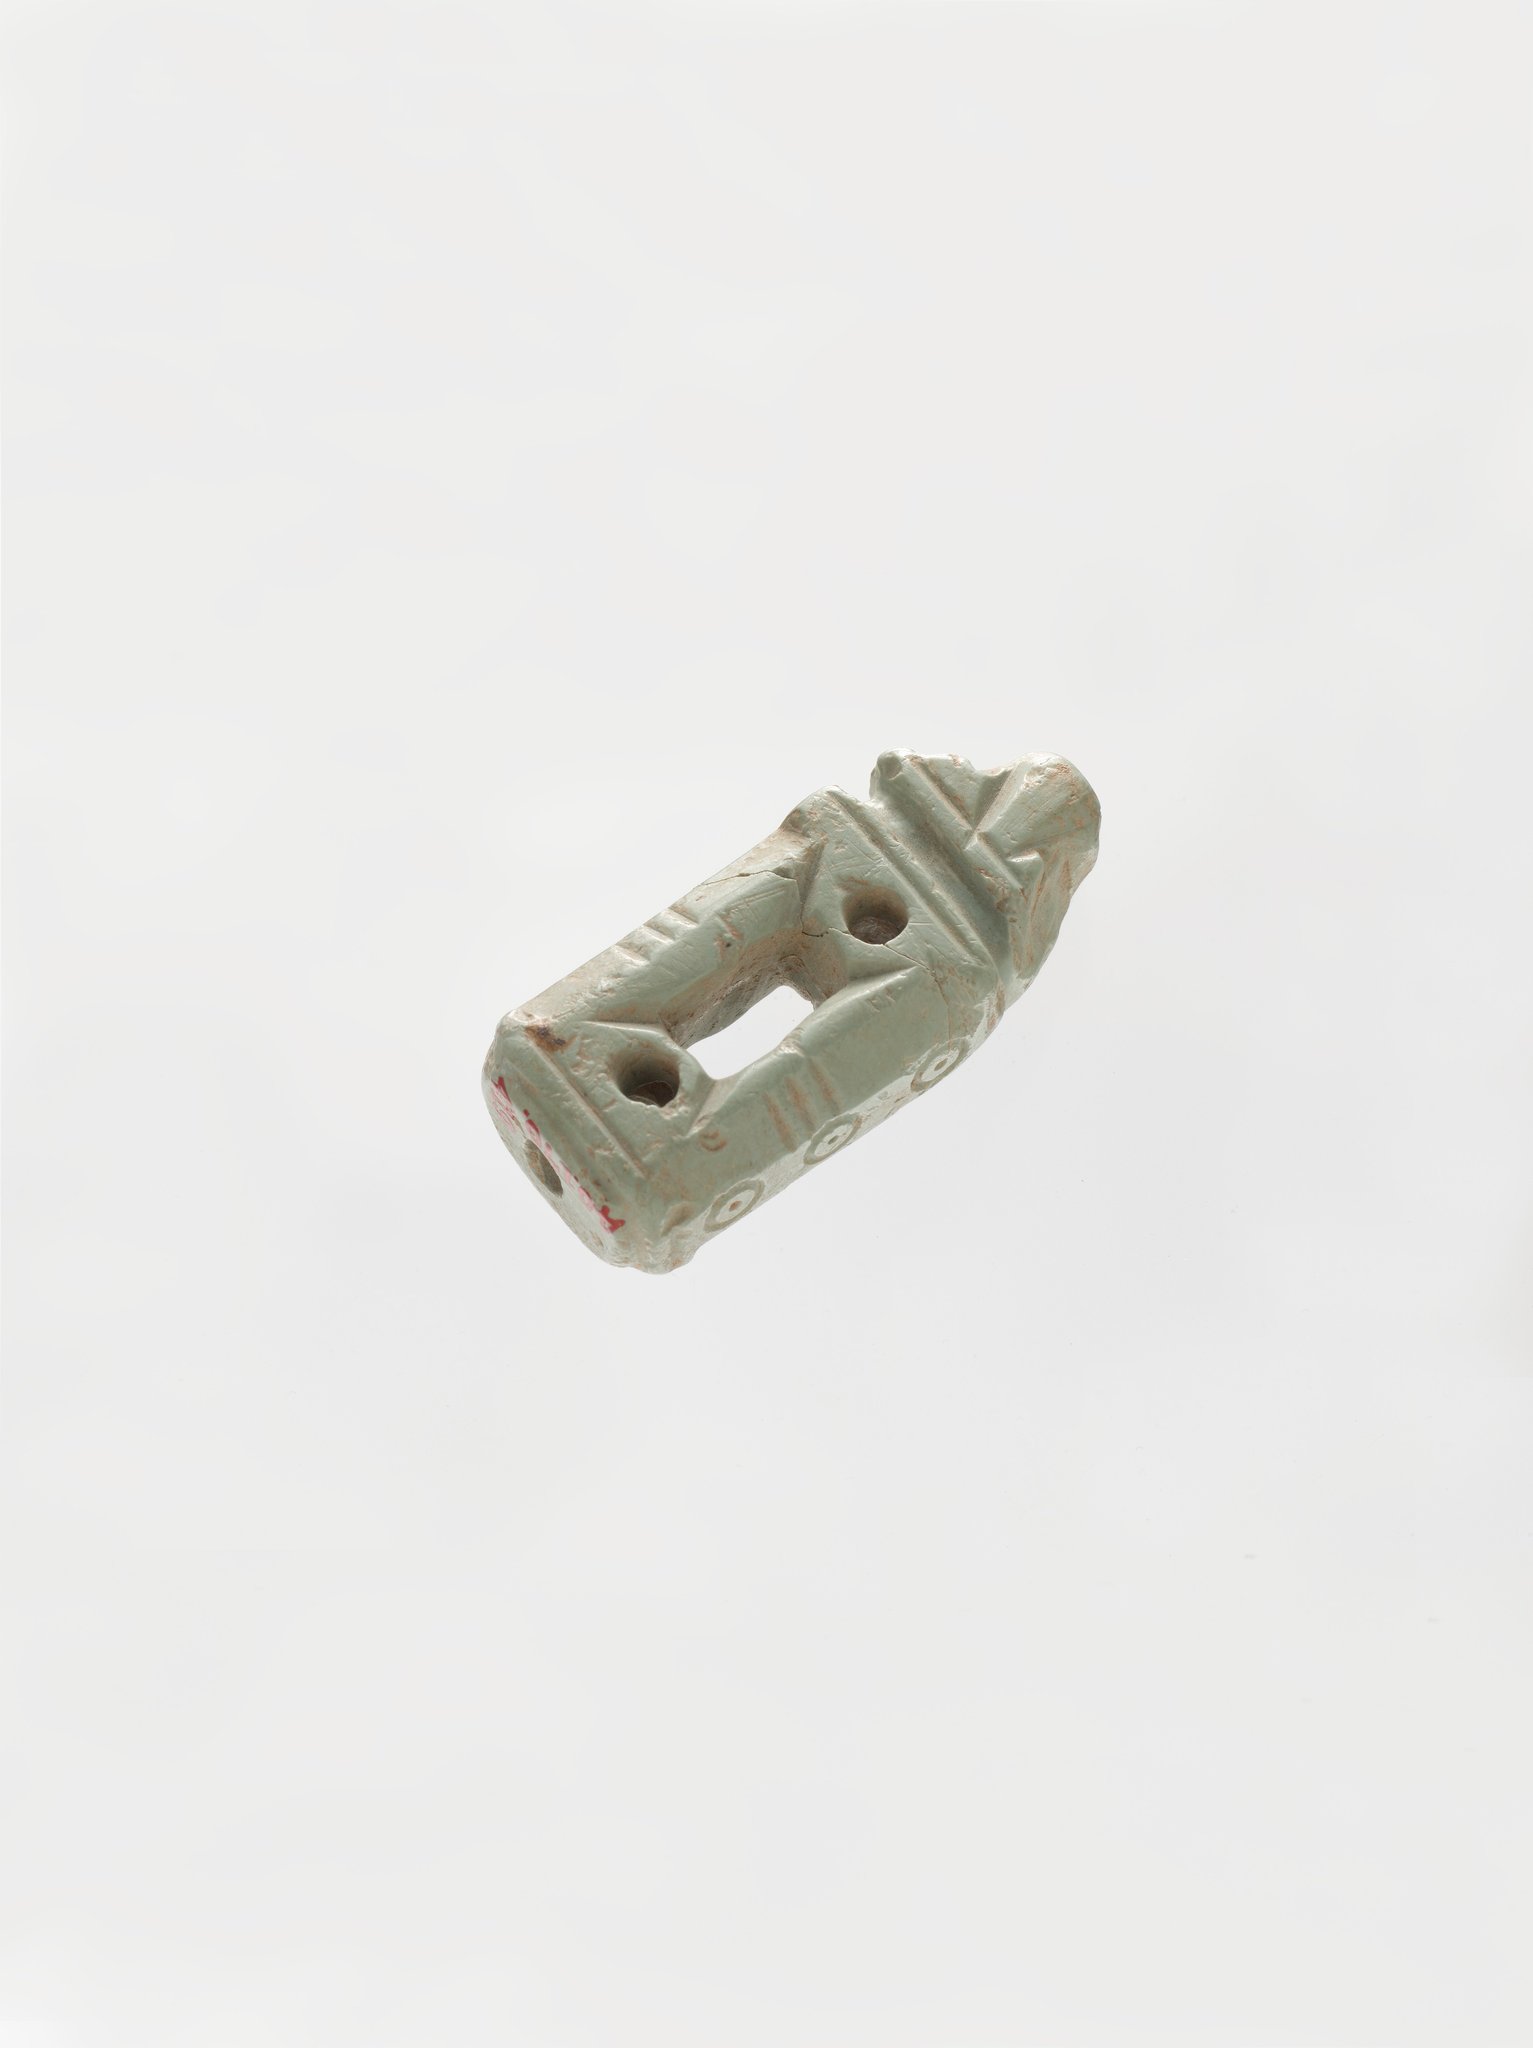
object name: pendant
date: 801-1000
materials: stone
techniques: carving, incising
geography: iran